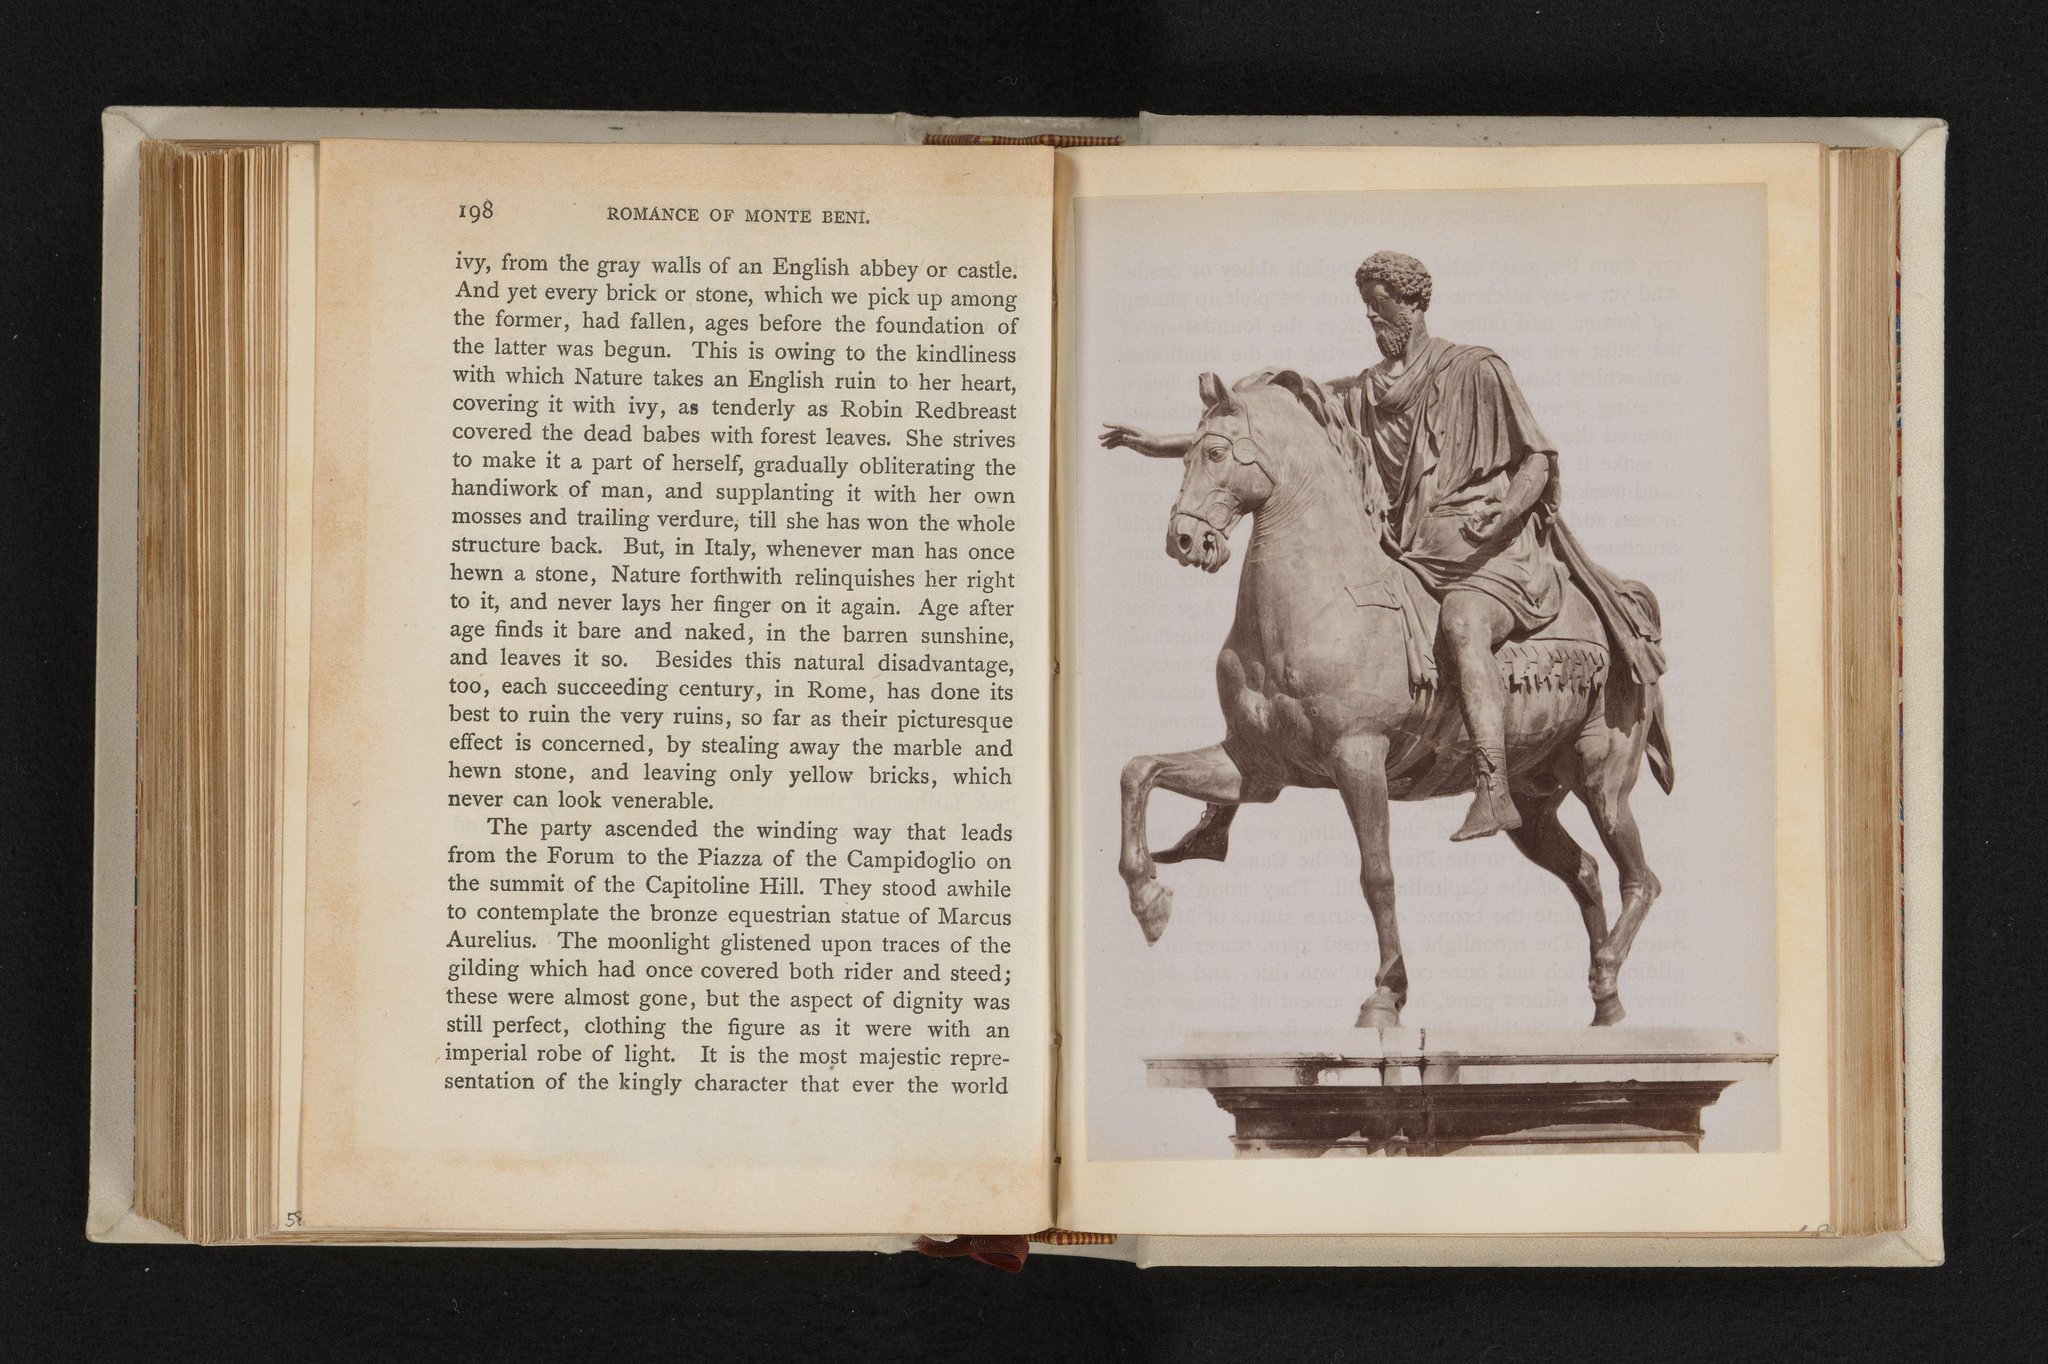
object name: photograph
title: Ruiterstandbeeld van Marcus Aurelius op het Piazza del Campidoglio in Rome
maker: Anonymous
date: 1850-1860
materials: photographic support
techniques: albumen print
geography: rome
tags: equestrian statue